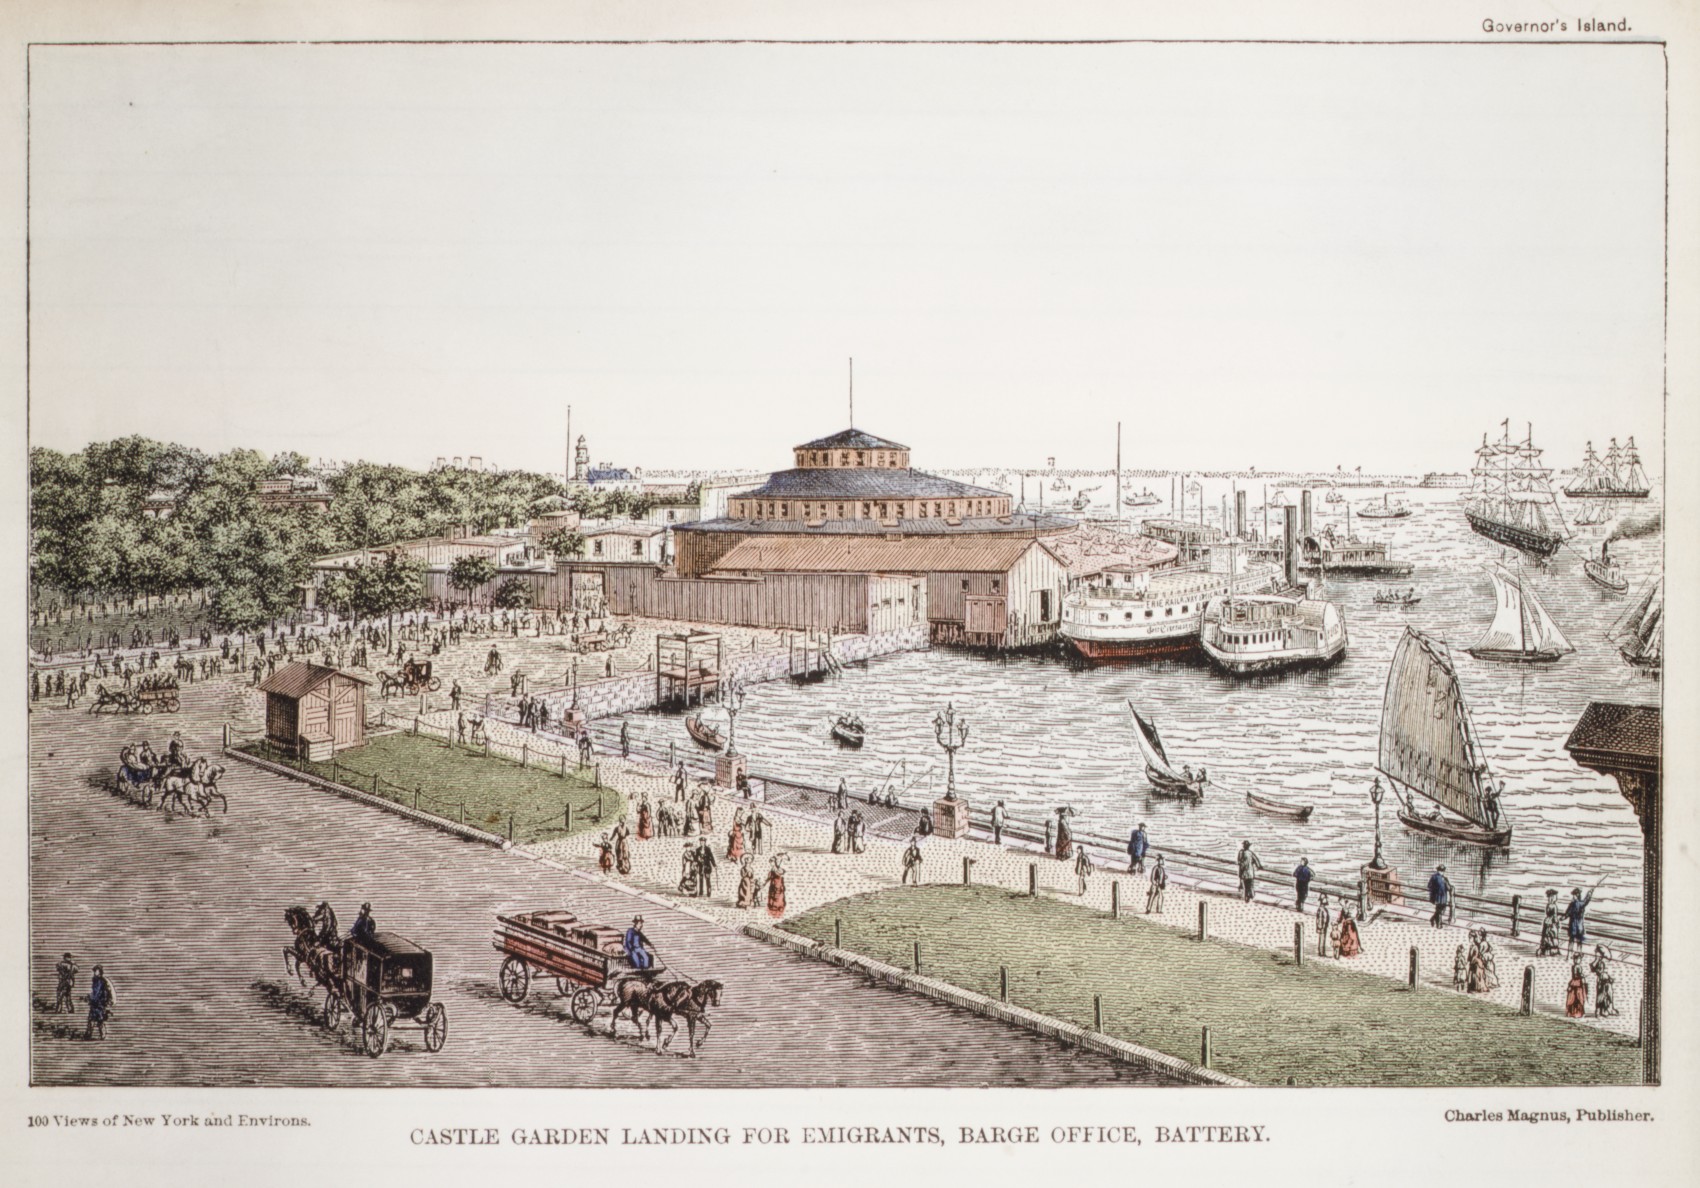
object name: print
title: Castle Garden Landing for Emigrants, Barge Office, Battery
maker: charles magnus & company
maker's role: publisher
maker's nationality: american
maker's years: 1854-1880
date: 1850-1900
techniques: hand coloring, engraving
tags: boats,carriages,ships,new york city